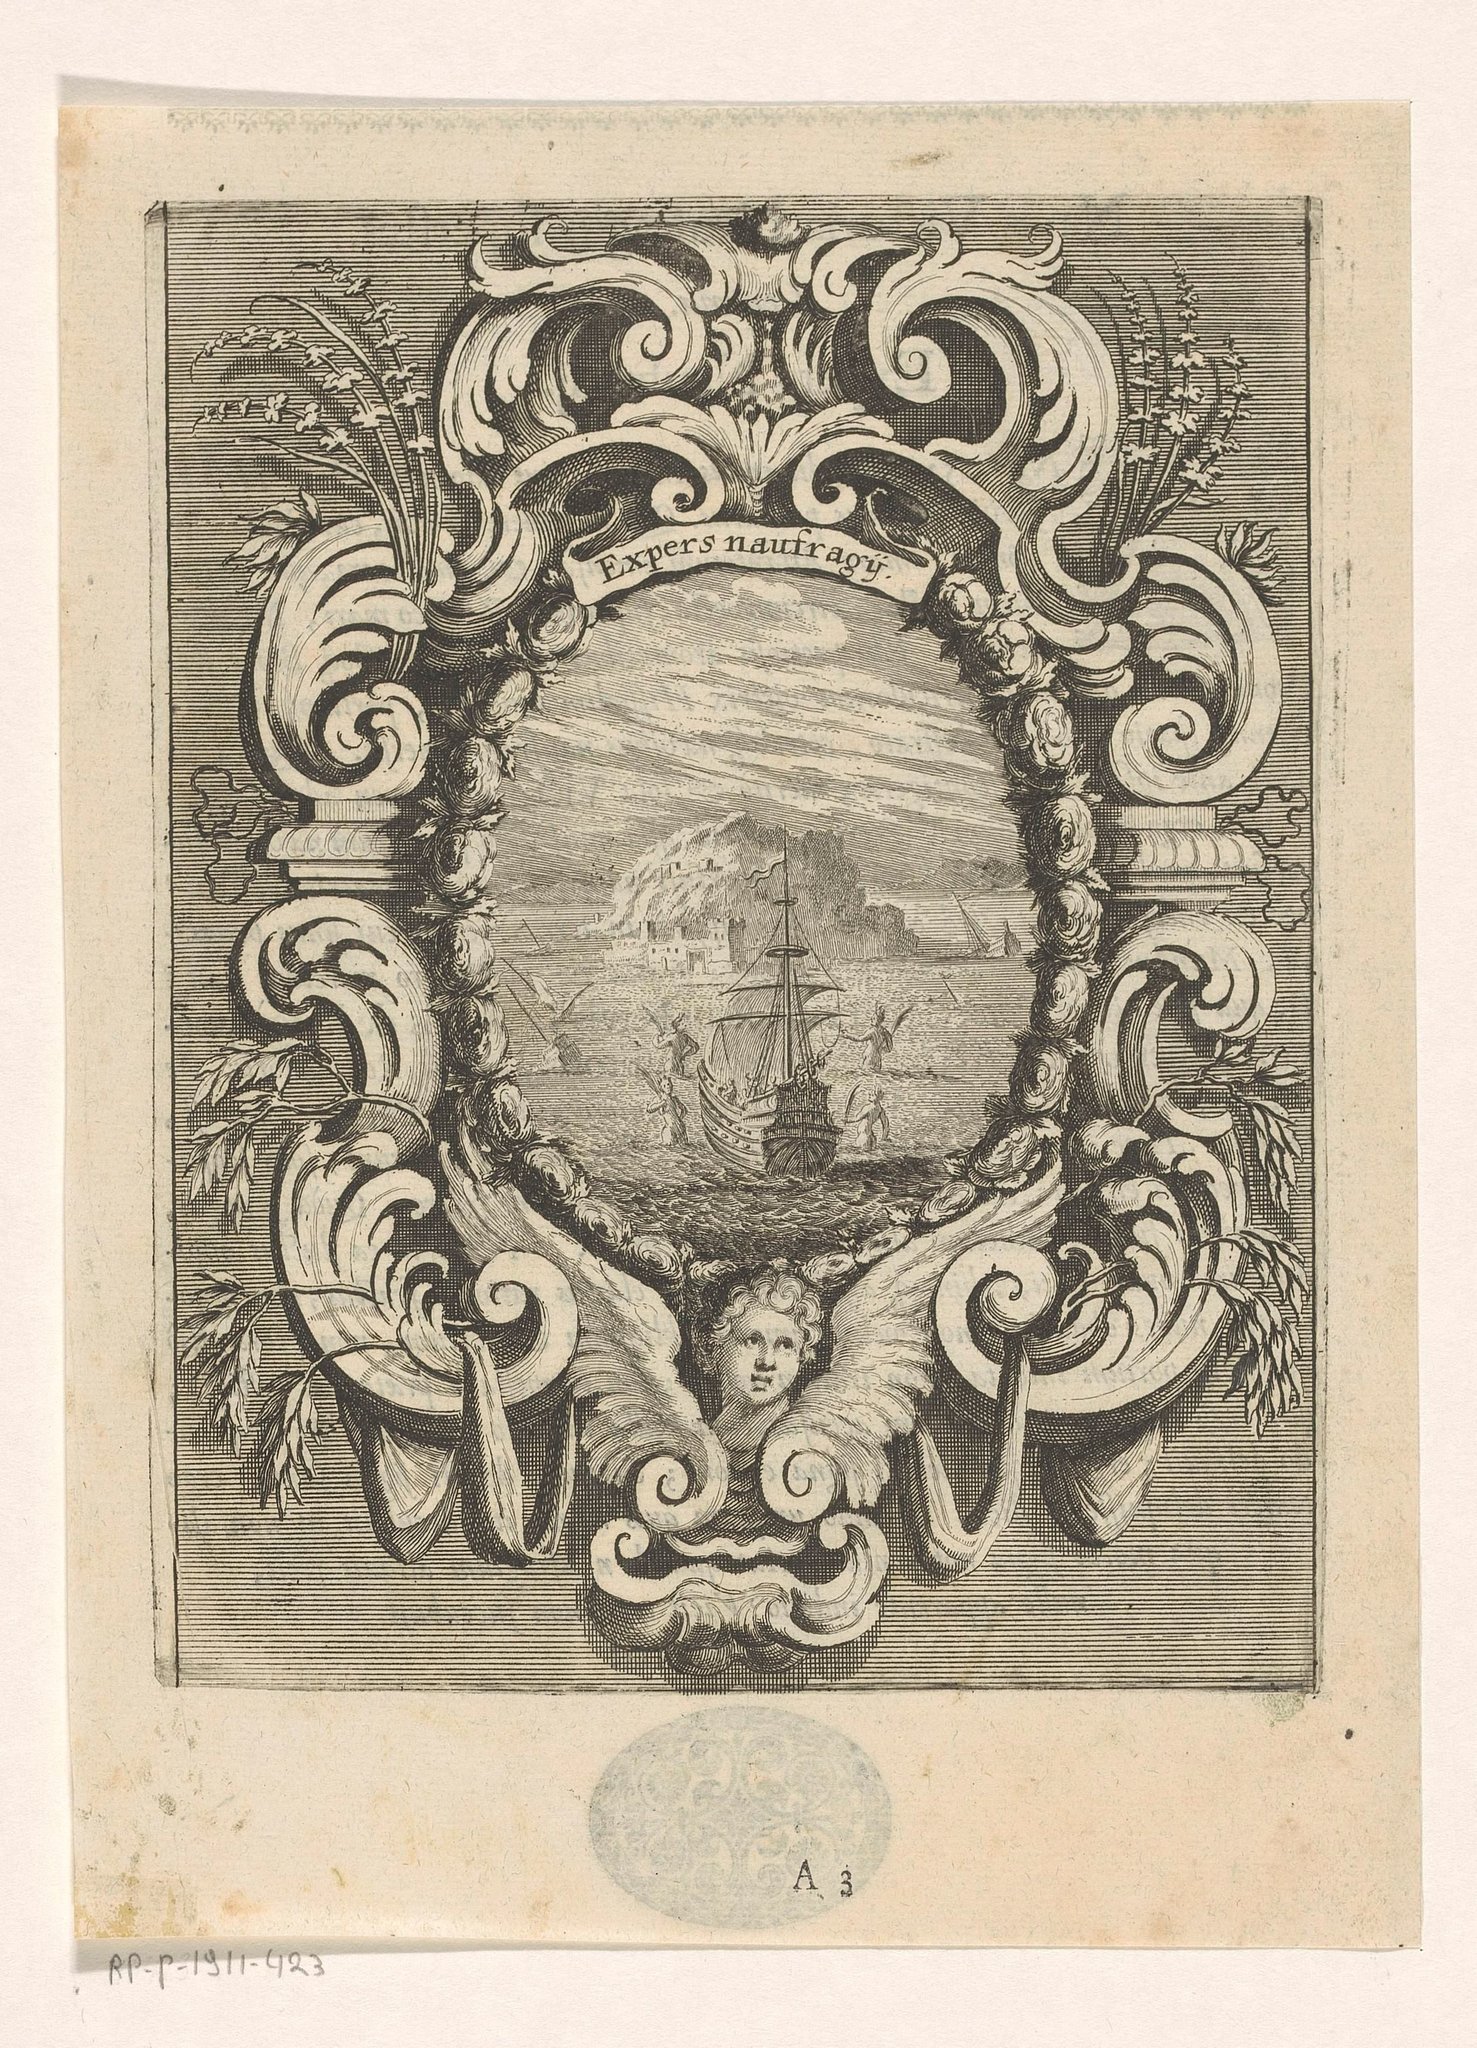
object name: book illustration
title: Pars posterior symbolica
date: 1695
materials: paper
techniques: etching, letterpress printing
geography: sankt gallen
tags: island, shipwreck, ships (in general), abstract ideas and concepts (+ emblematical representation of concept), spirit of water, nix, undine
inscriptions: collector's mark: Lugt 2228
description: Cartouche met embleem. Het embleem toont een schip op zee dat richting een havenstad vaart, gelegen op een eiland. Rondom het eiland liggen wrakken van andere schepen. Dit schip vaart echter op koers, onder begeleiding van vier zeecreaturen met palmtakken in hun handen. Latijns motto op de banderol